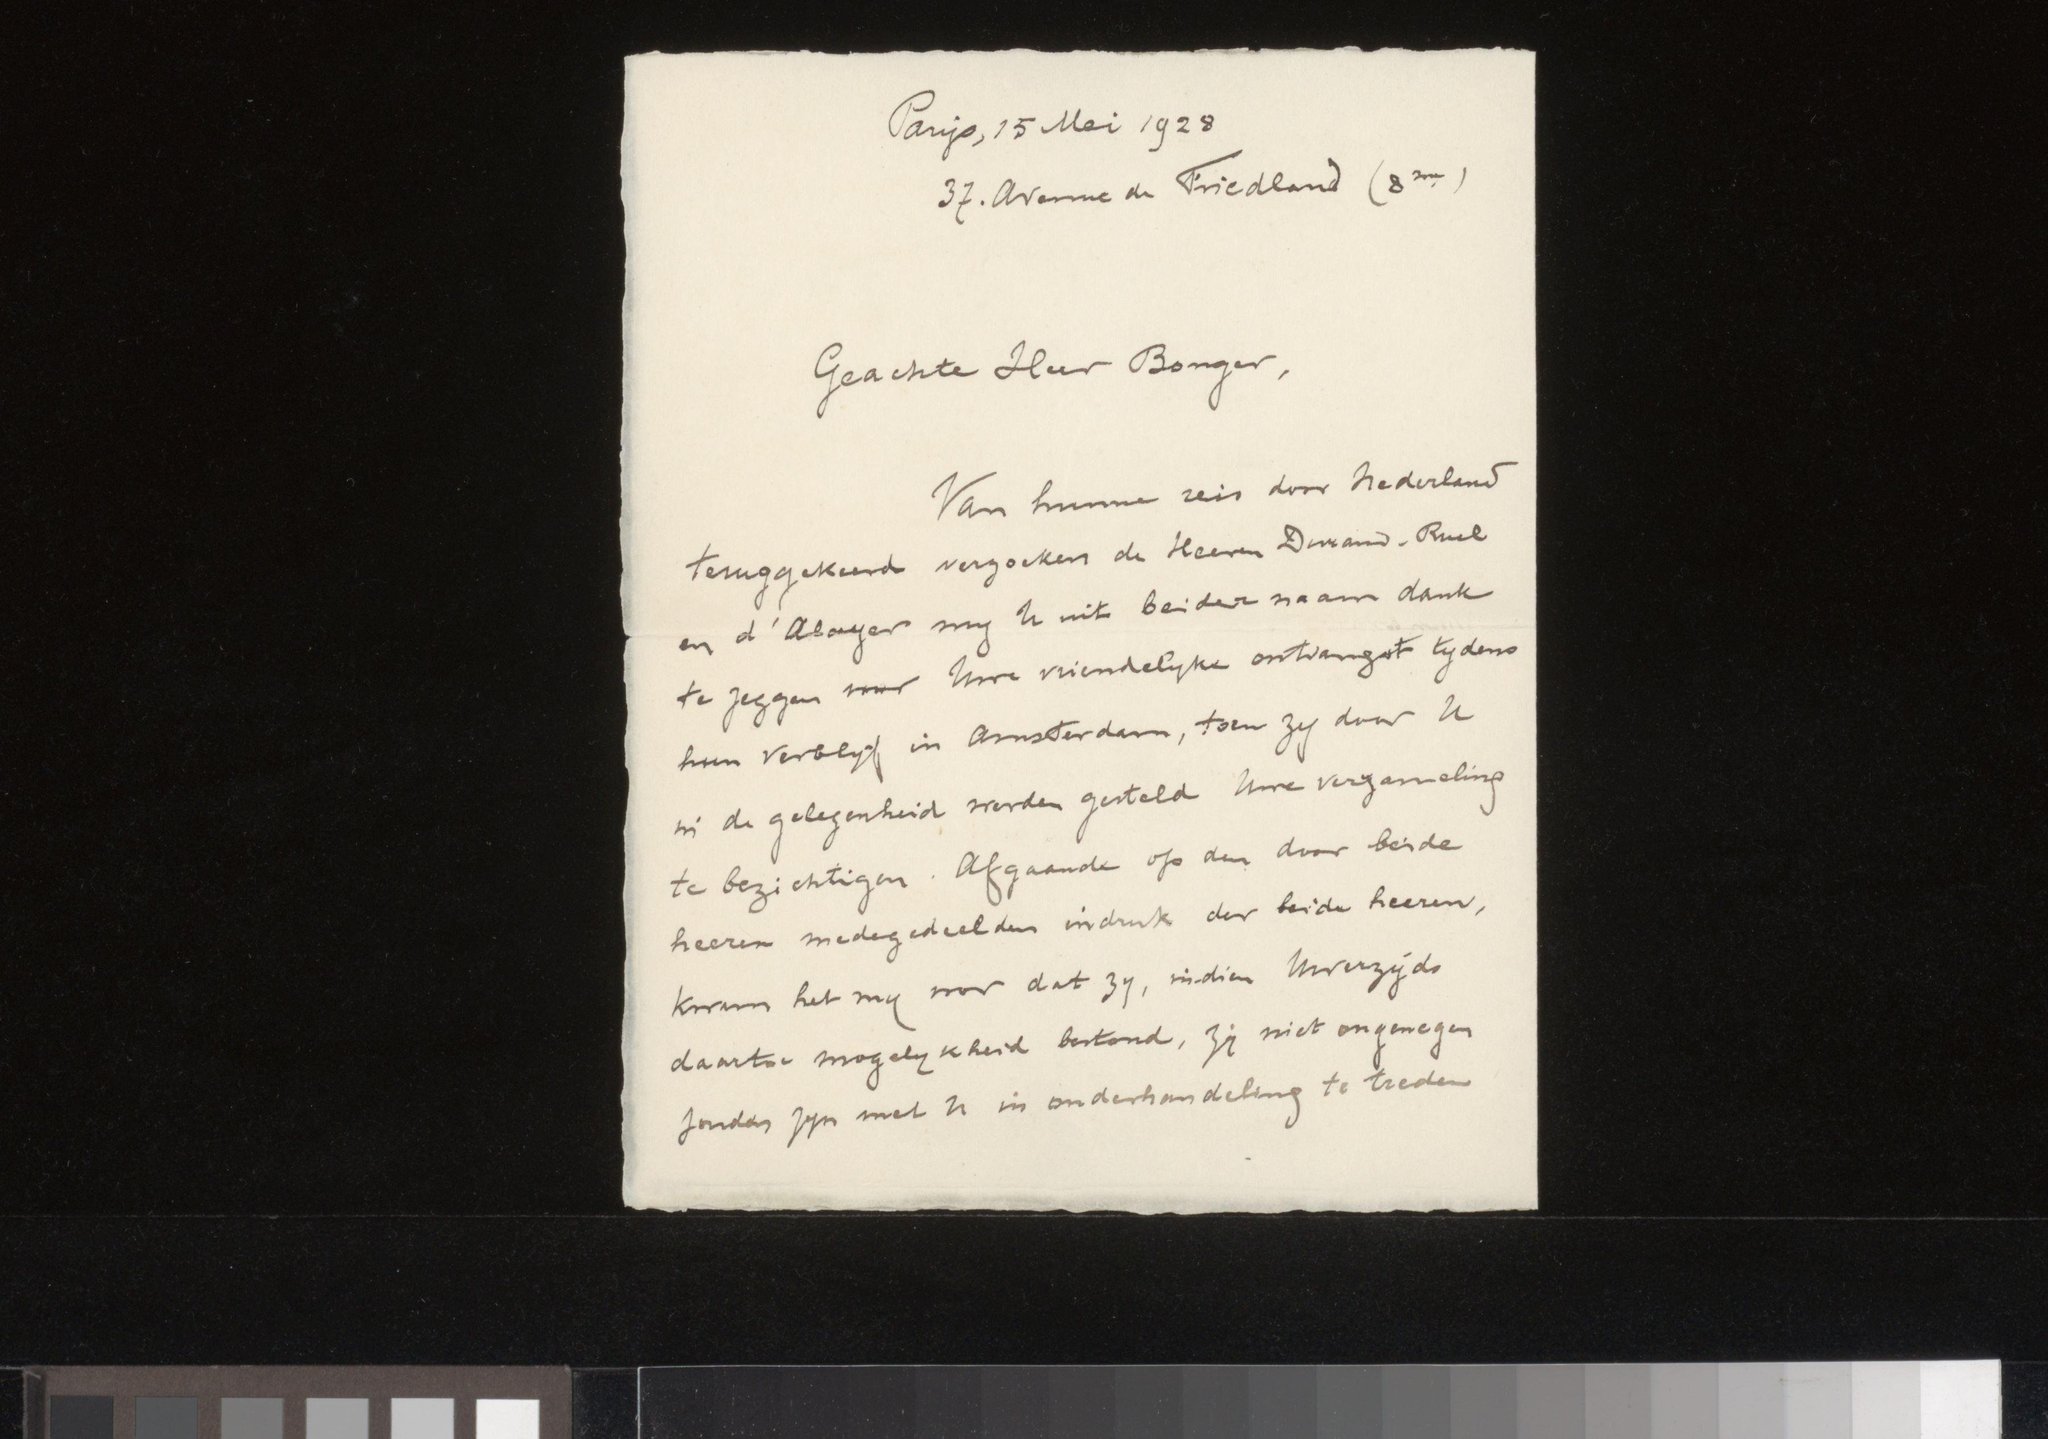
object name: letter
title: Brief aan Andries Bonger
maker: c. destree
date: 1871-1936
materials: ink, paper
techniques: pen, writing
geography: paris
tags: andries bonger, paris, paul durand-ruel, engineer, vincent willem van gogh, art trade, art shop, art collecting, amsterdam